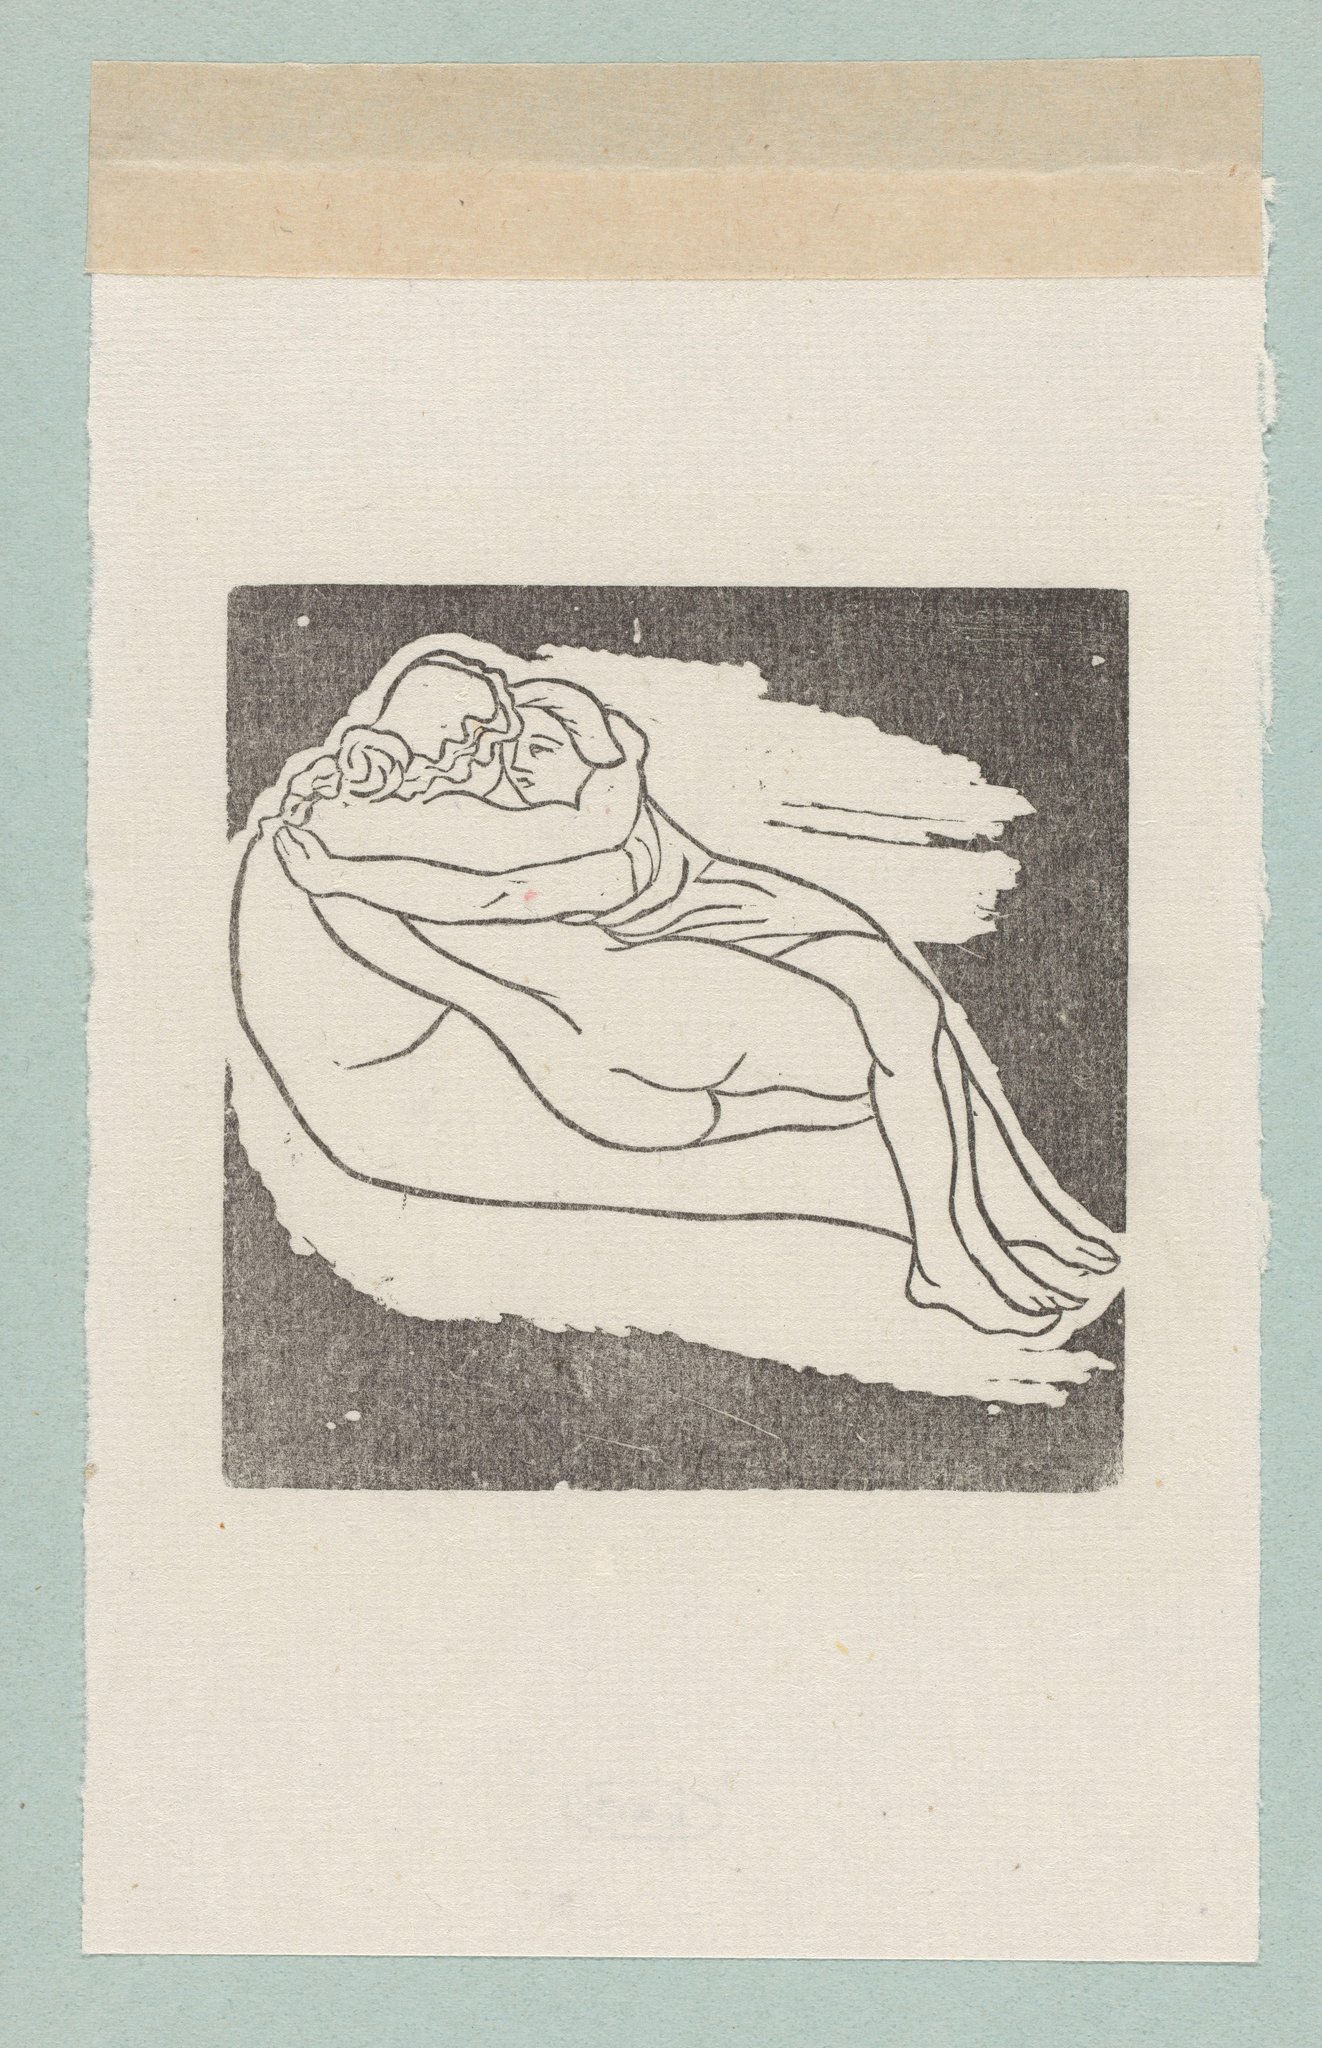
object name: book illustration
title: Daphnis en Chloë samen liggend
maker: aristide maillol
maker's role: draughtsman, painter, print maker, sculptor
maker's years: 1861-1944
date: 1937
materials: paper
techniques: woodcut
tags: daphnis (in greek mythology a shepherd who invented pastoral poetry, chloe, couple of lovers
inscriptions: collector's mark: Lugt 2228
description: Deze prent werd ontworpen als boekillustratie, maar nooit gebruikt in: Longus. Les Pastorales de Longus ou Daphnis & Chloé. Parijs: Frères Gonin, 1935.